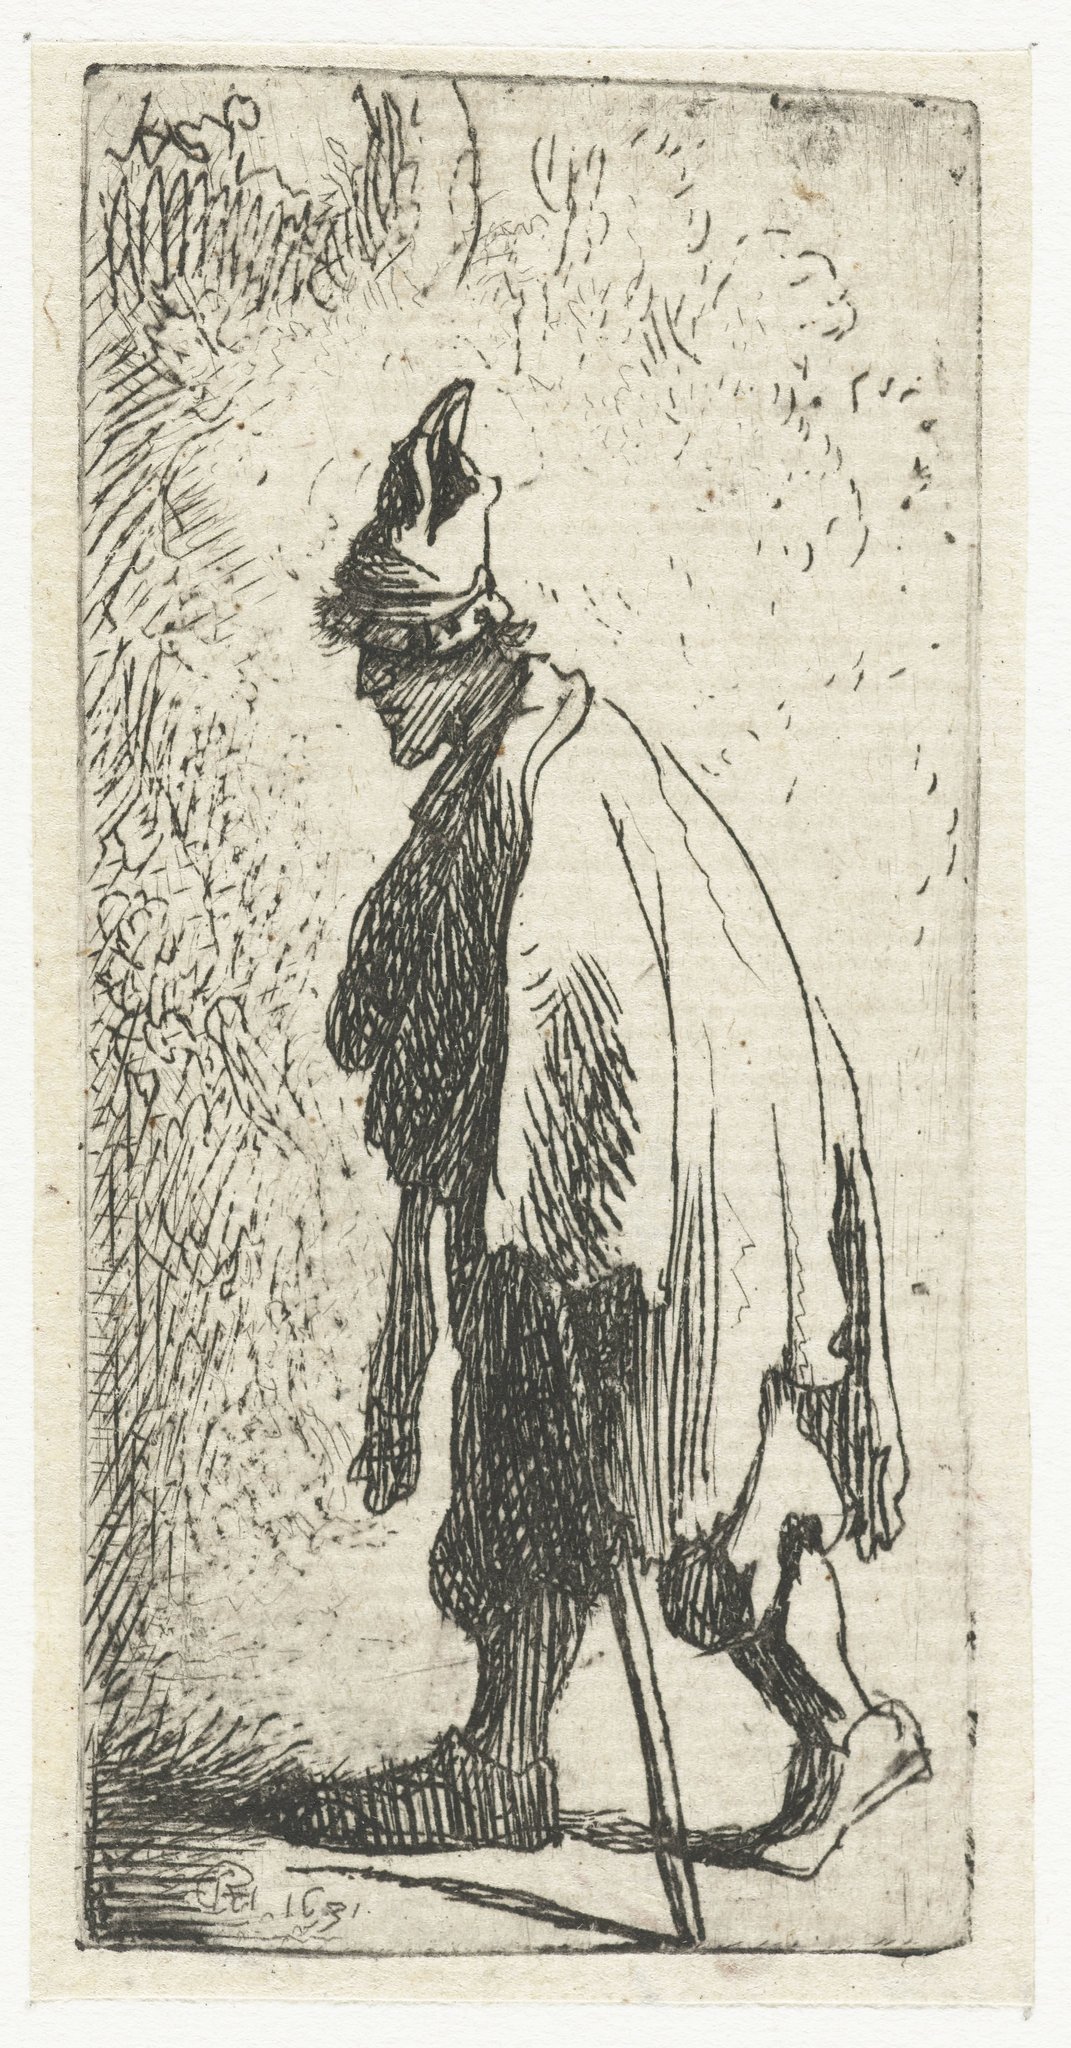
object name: print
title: Bedelaar met een stok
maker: Anonymous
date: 1631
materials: paper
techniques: etching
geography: netherlands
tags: beggar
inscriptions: collector's mark: Lugt 240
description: Volgens Hollstein (Rembrandt, cat.nr. 167) een Lievens-achtige achtergrond, Münz schrijft de prent toe aan Van Vliet (cat.nr. 285), maar dit is niet overtuigend.